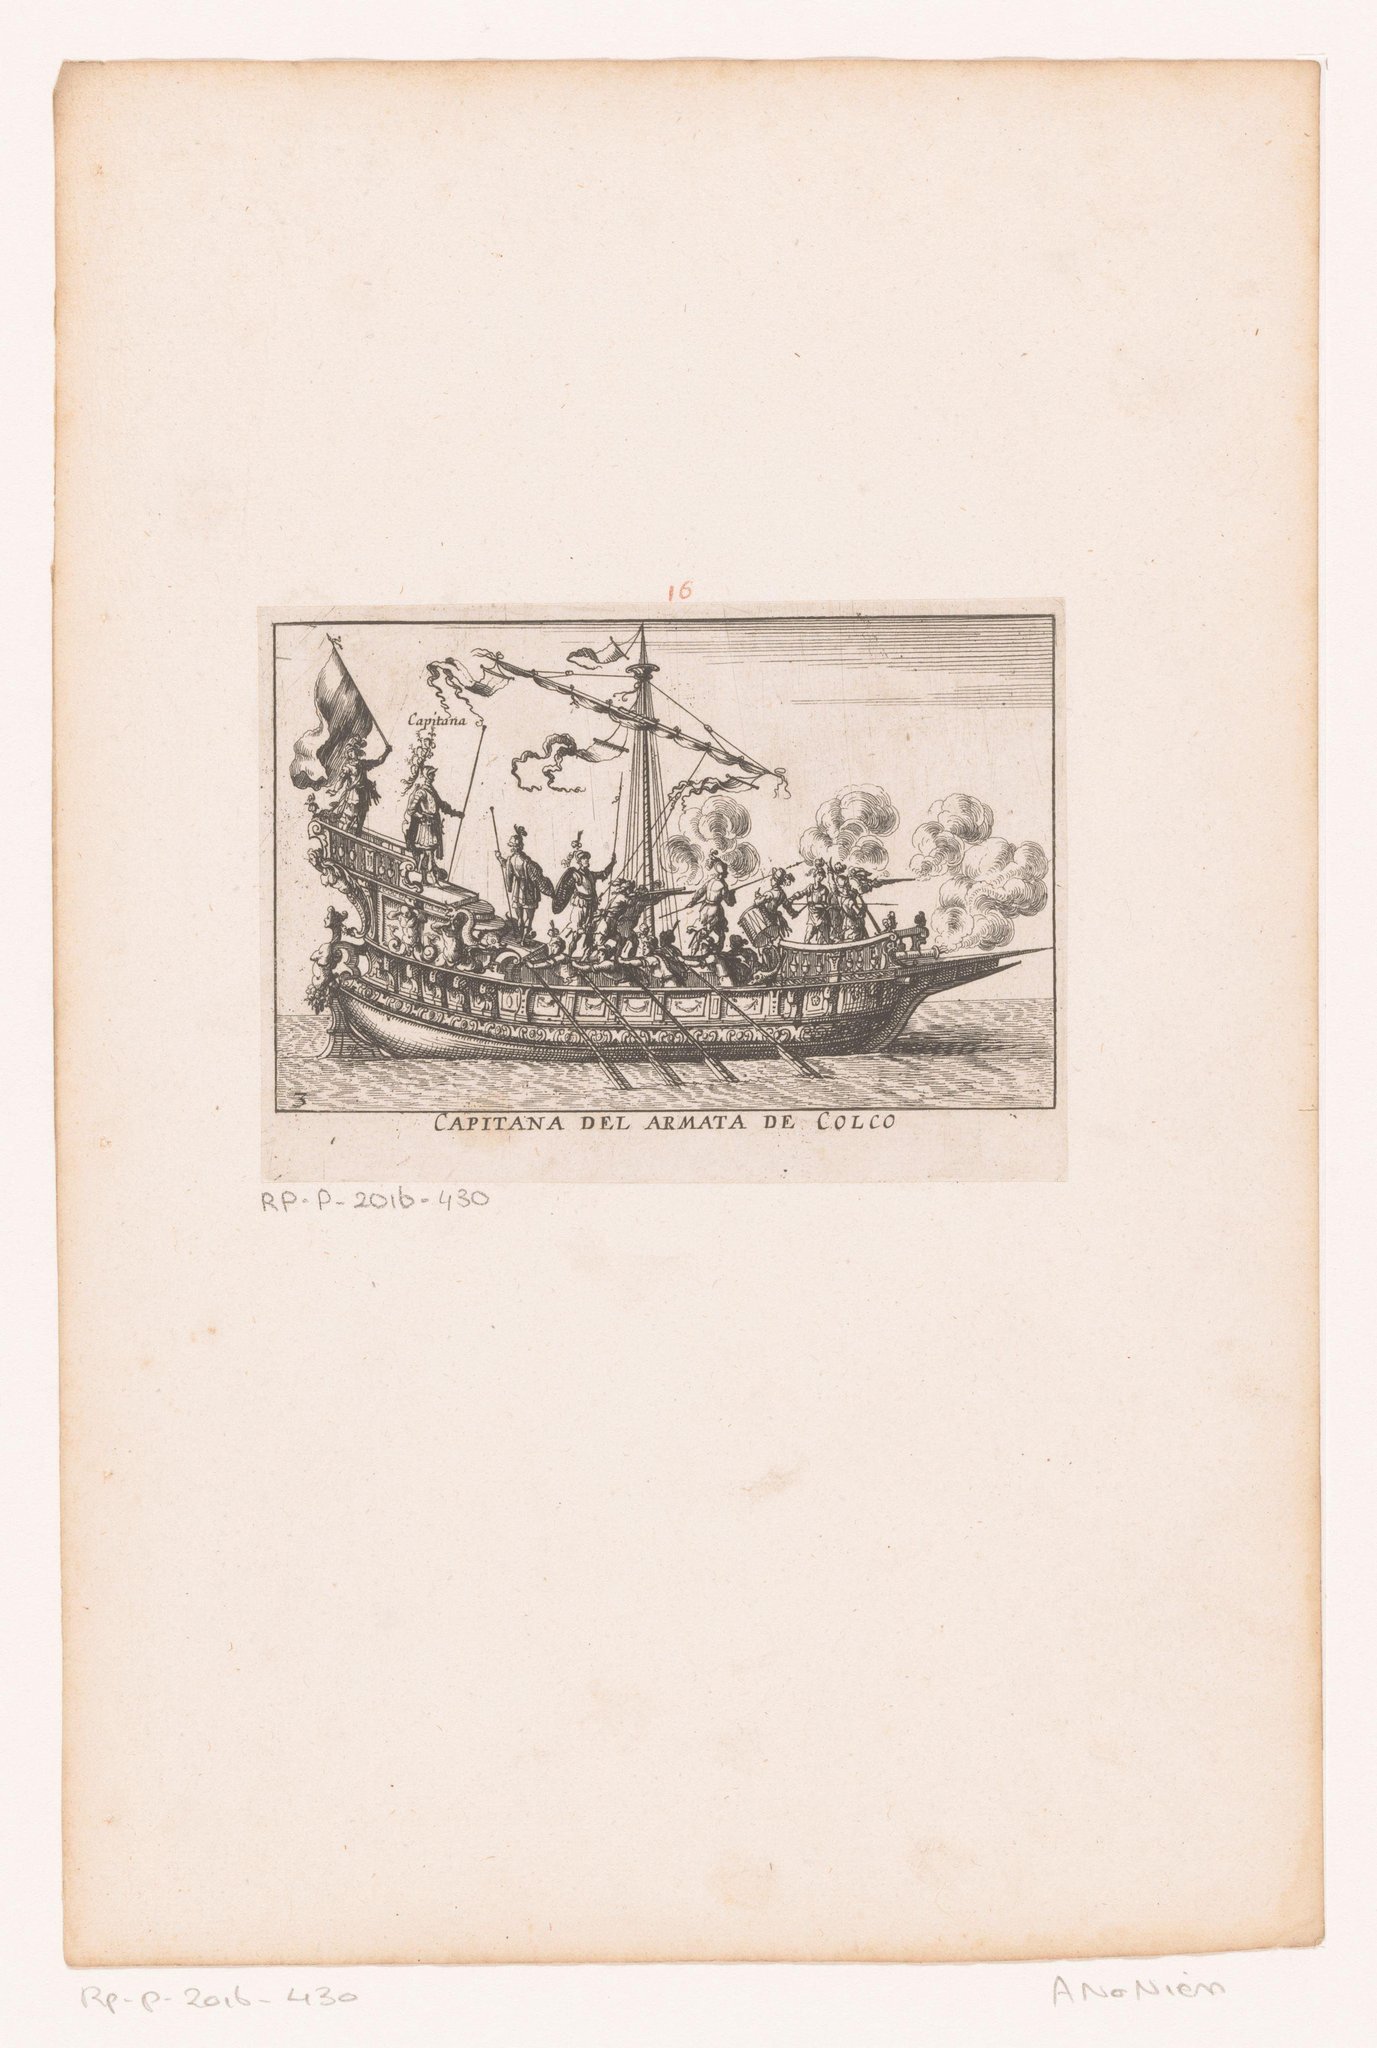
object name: print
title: Capitana del armata de Colco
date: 1624-1631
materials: paper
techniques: etching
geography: paris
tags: crew ~ ship, ships (in general), the story of the argonauts: the quest for the golden fleece, the soldier; the soldier's life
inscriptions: number: ‘16’, collector's mark: Lugt 2228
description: Een schip met schietende soldaten op het voorsteven, op het achtersteven staat de kapitein.